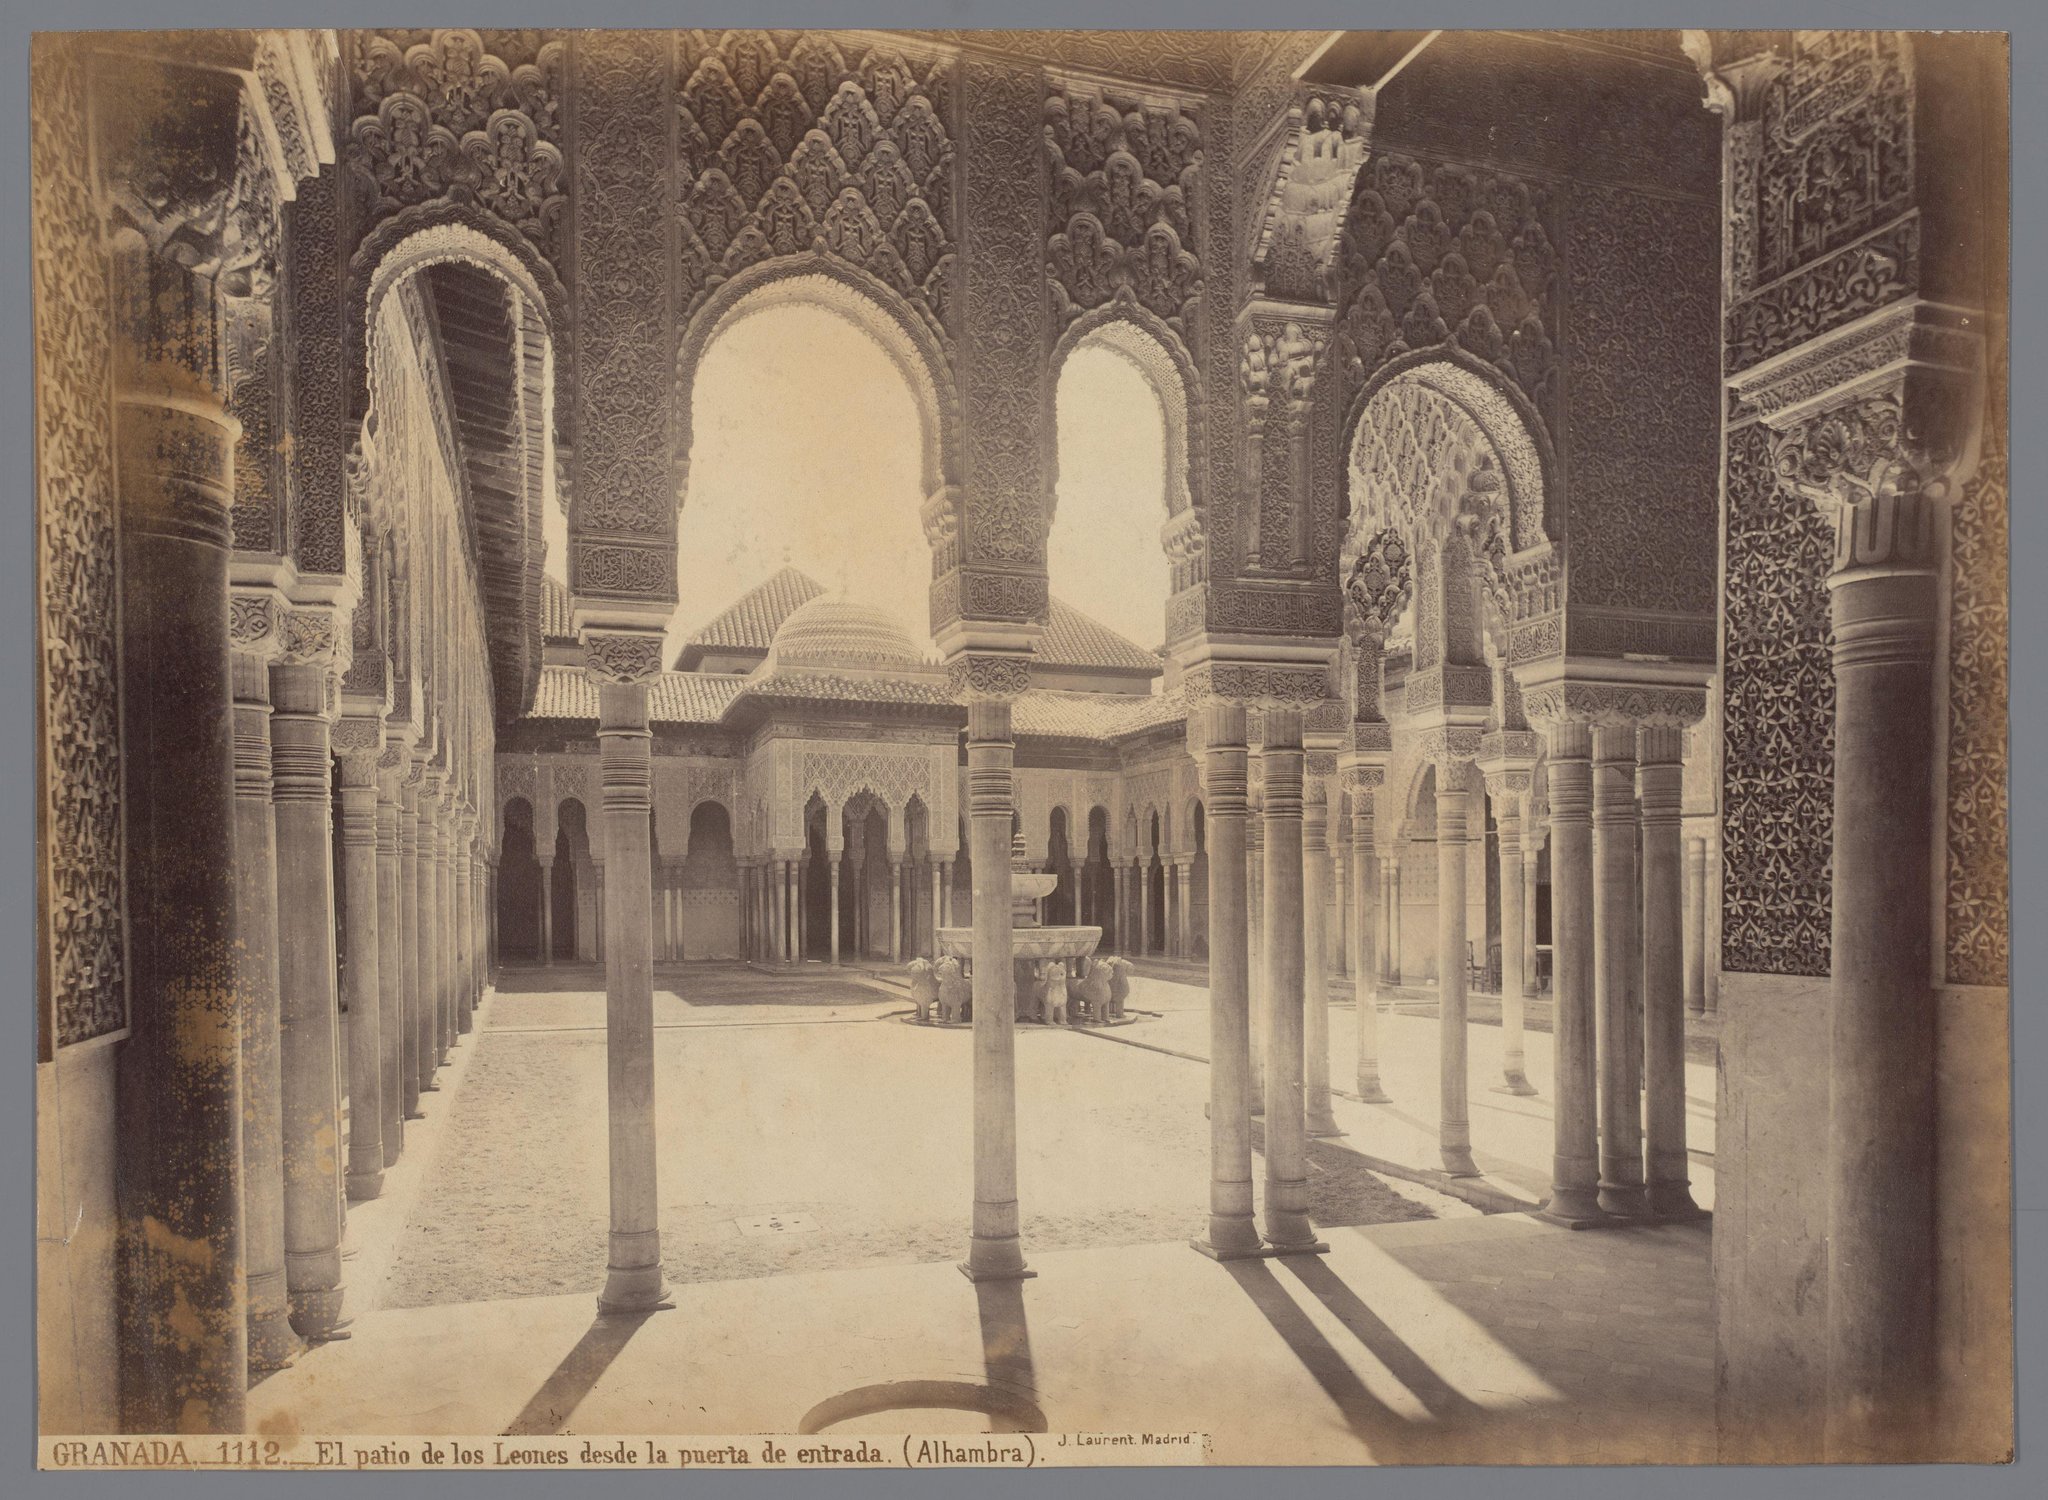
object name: photograph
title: Gezicht op binnenplaats (El Patio de los Leones) van Alhambra, Granada, Spanje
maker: juan laurent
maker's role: publisher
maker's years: 1816-1896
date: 1850-1900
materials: paper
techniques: albumen print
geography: madrid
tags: alhambra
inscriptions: caption: ‘GRANADA.1112. El patio de los Leones desde la puerta de entrada (Alhambra)’, annotation: ‘X’, caption: ‘J. Laurent. Madrid.’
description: Gezicht op binnenplaats El patio de los Leones van Alhambra, Granada, Spanje.